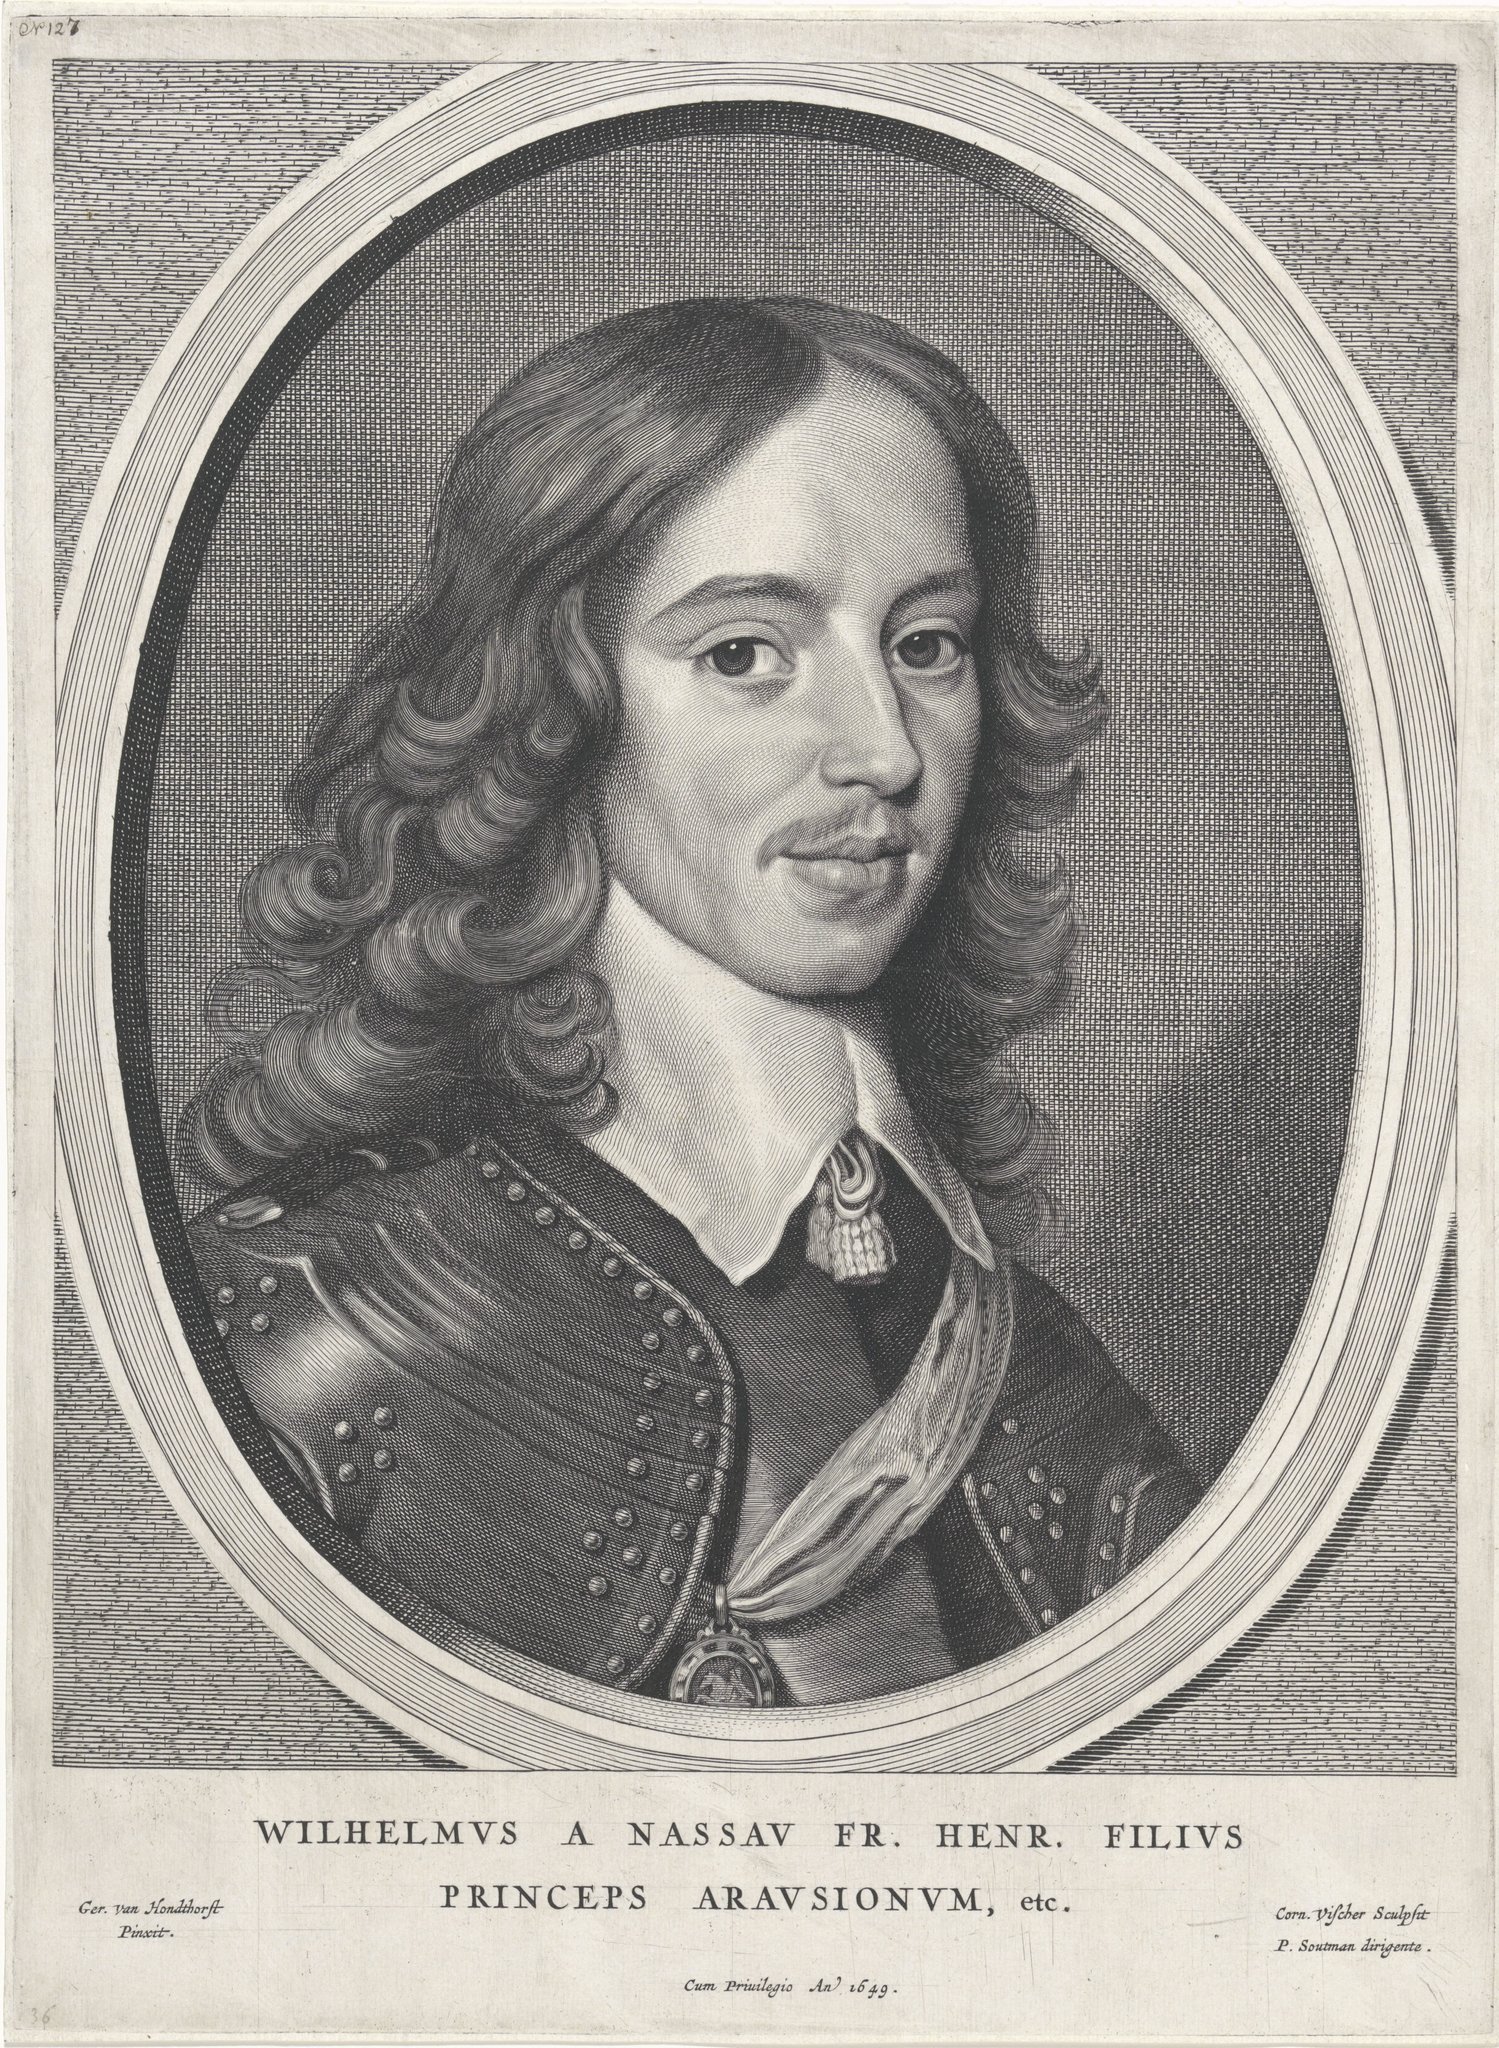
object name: print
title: Portret van Willem II, prins van Oranje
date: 1649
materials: paper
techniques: engraving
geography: haarlem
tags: william ii (prince of orange), knighthood order, armour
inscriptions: collector's mark: Lugt 240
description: Willem II, prins van Oranje in een harnas. Om zijn hals het ordeteken van de orde van de Kousenband. Prent uit een serie van 9 prenten met Oranjeportretten.